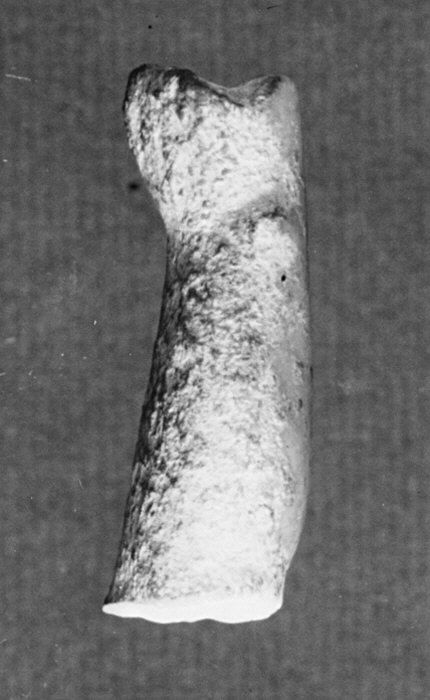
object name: statuette leg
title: Marble leg from a statuette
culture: cycladic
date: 3200-2200 BCE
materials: marble